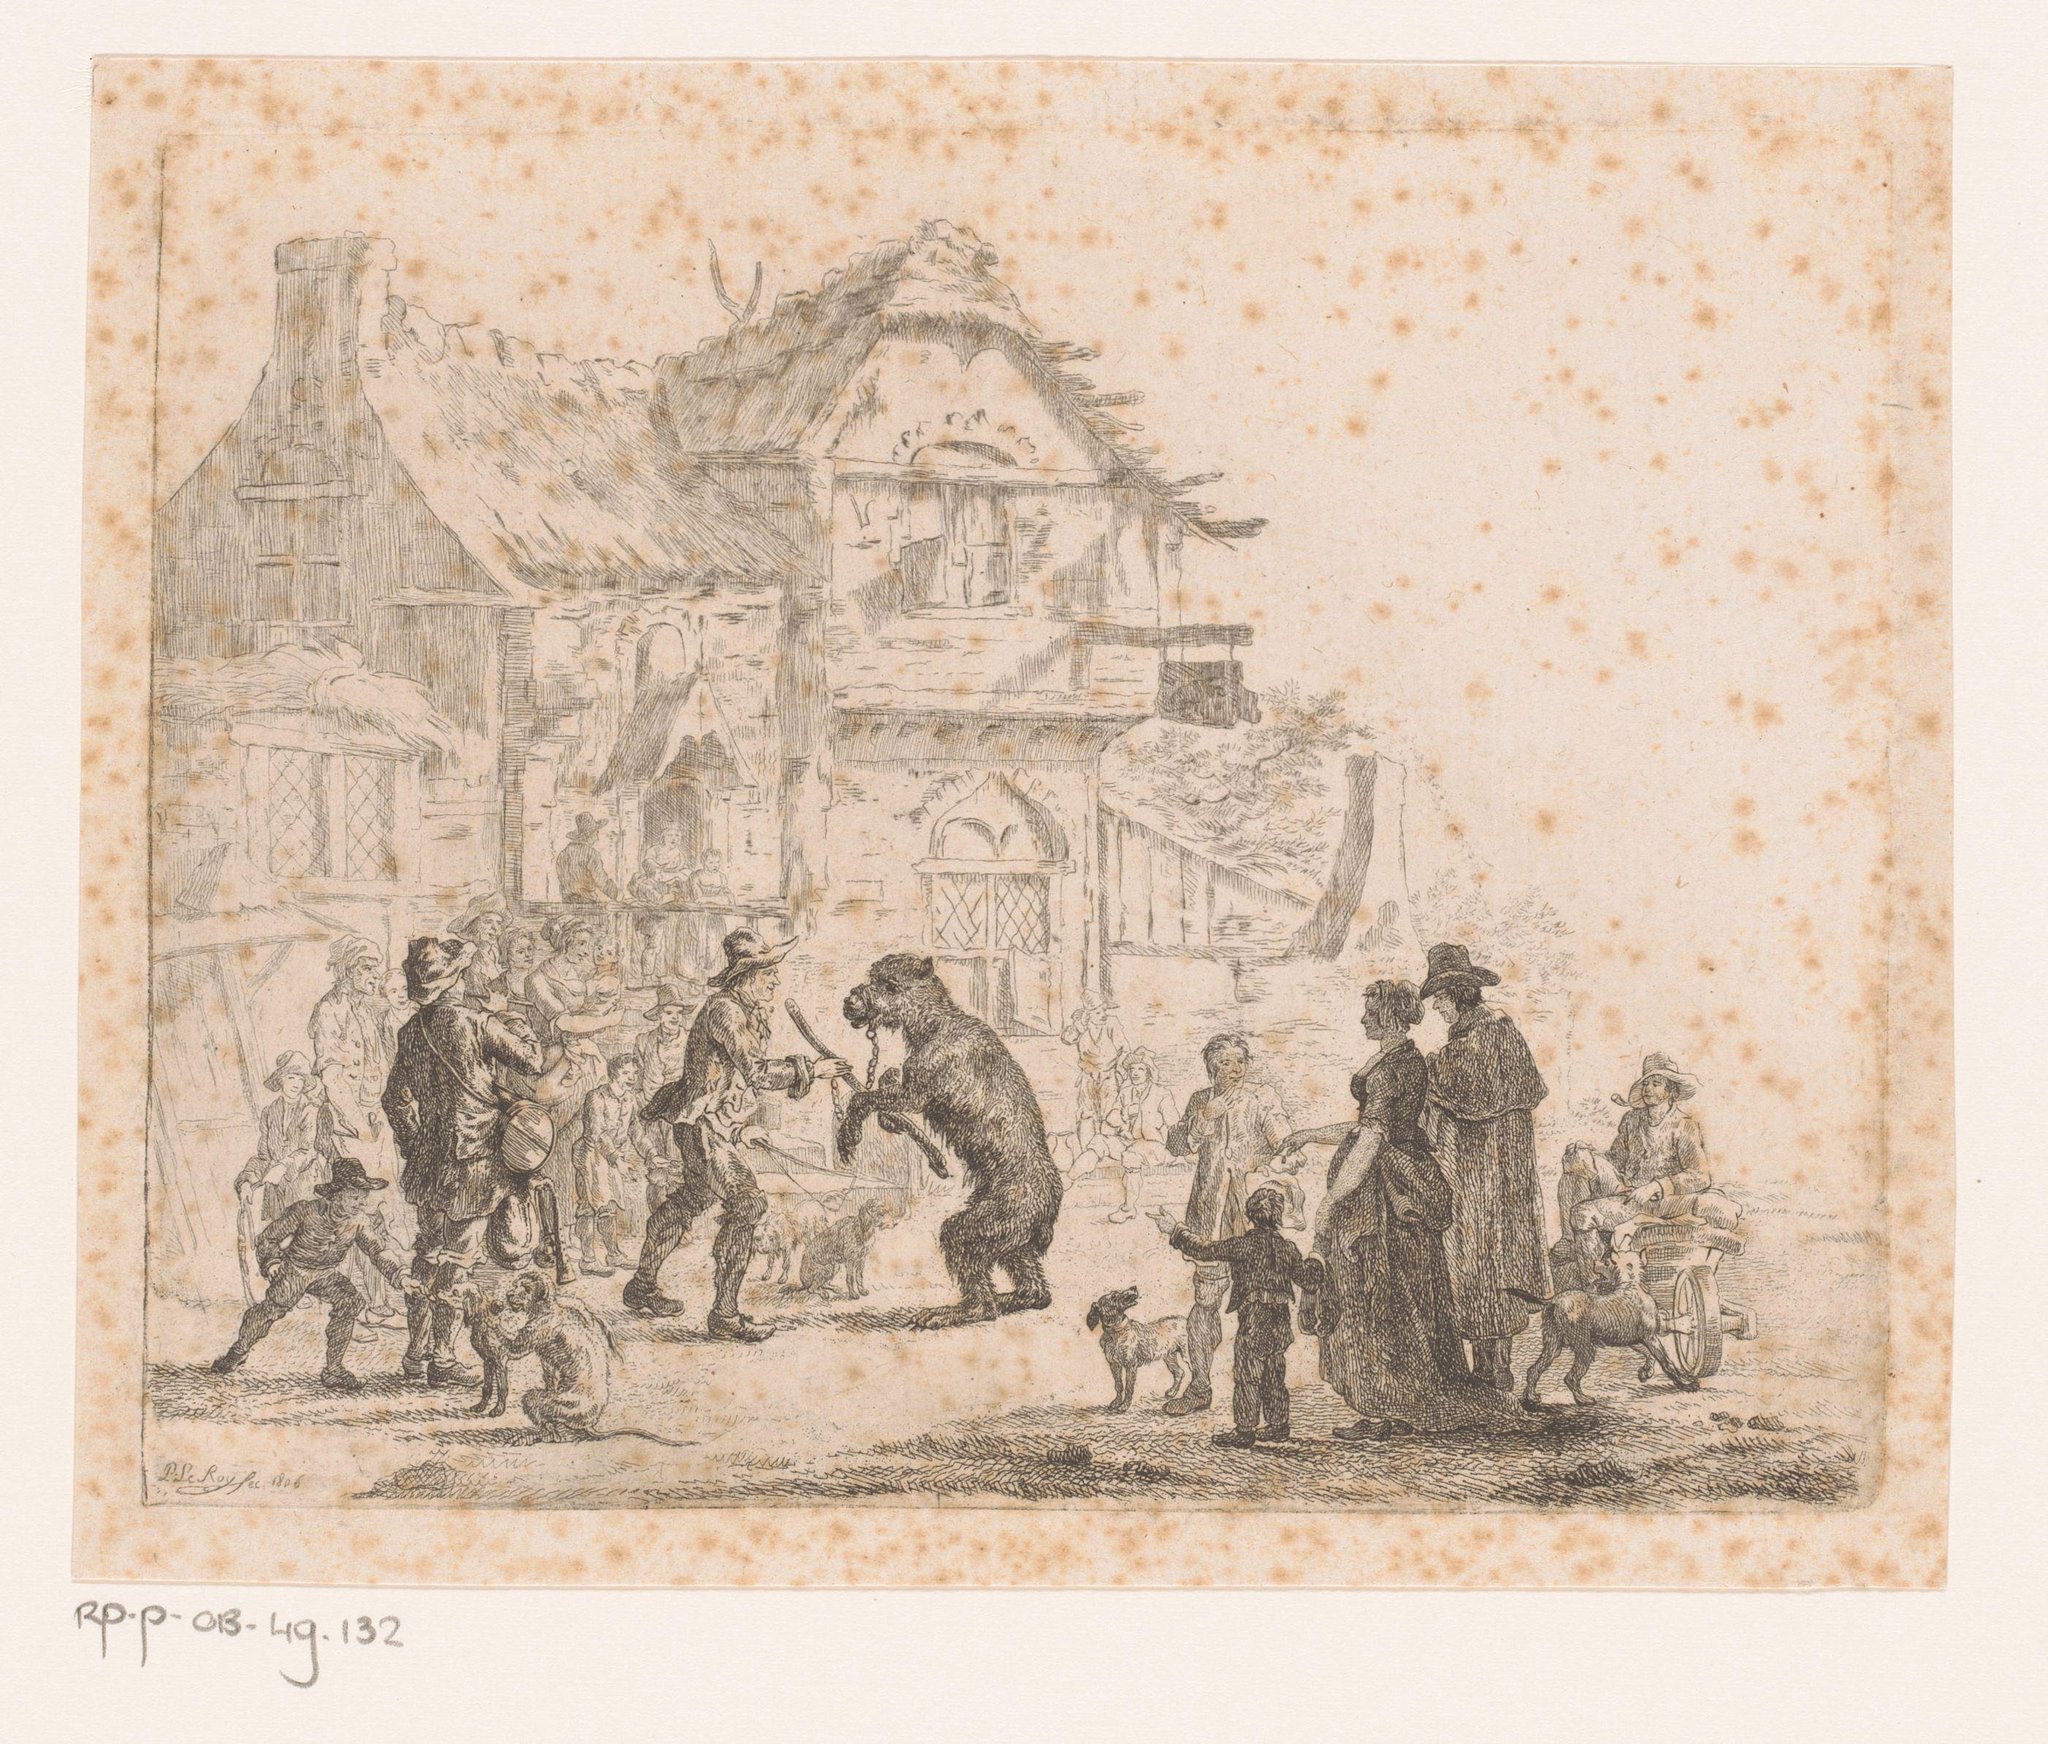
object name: print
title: Dansende beer met begeleider voor een herberg, op de voorgrond ook een aap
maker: pierre-françois le roy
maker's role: draughtsman, painter, print maker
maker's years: 1771-1862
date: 1806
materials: paper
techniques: etching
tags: bears (circus performance) (+ dancing ~ festive activities), earning money with monkey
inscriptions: collector's mark: Lugt 2228